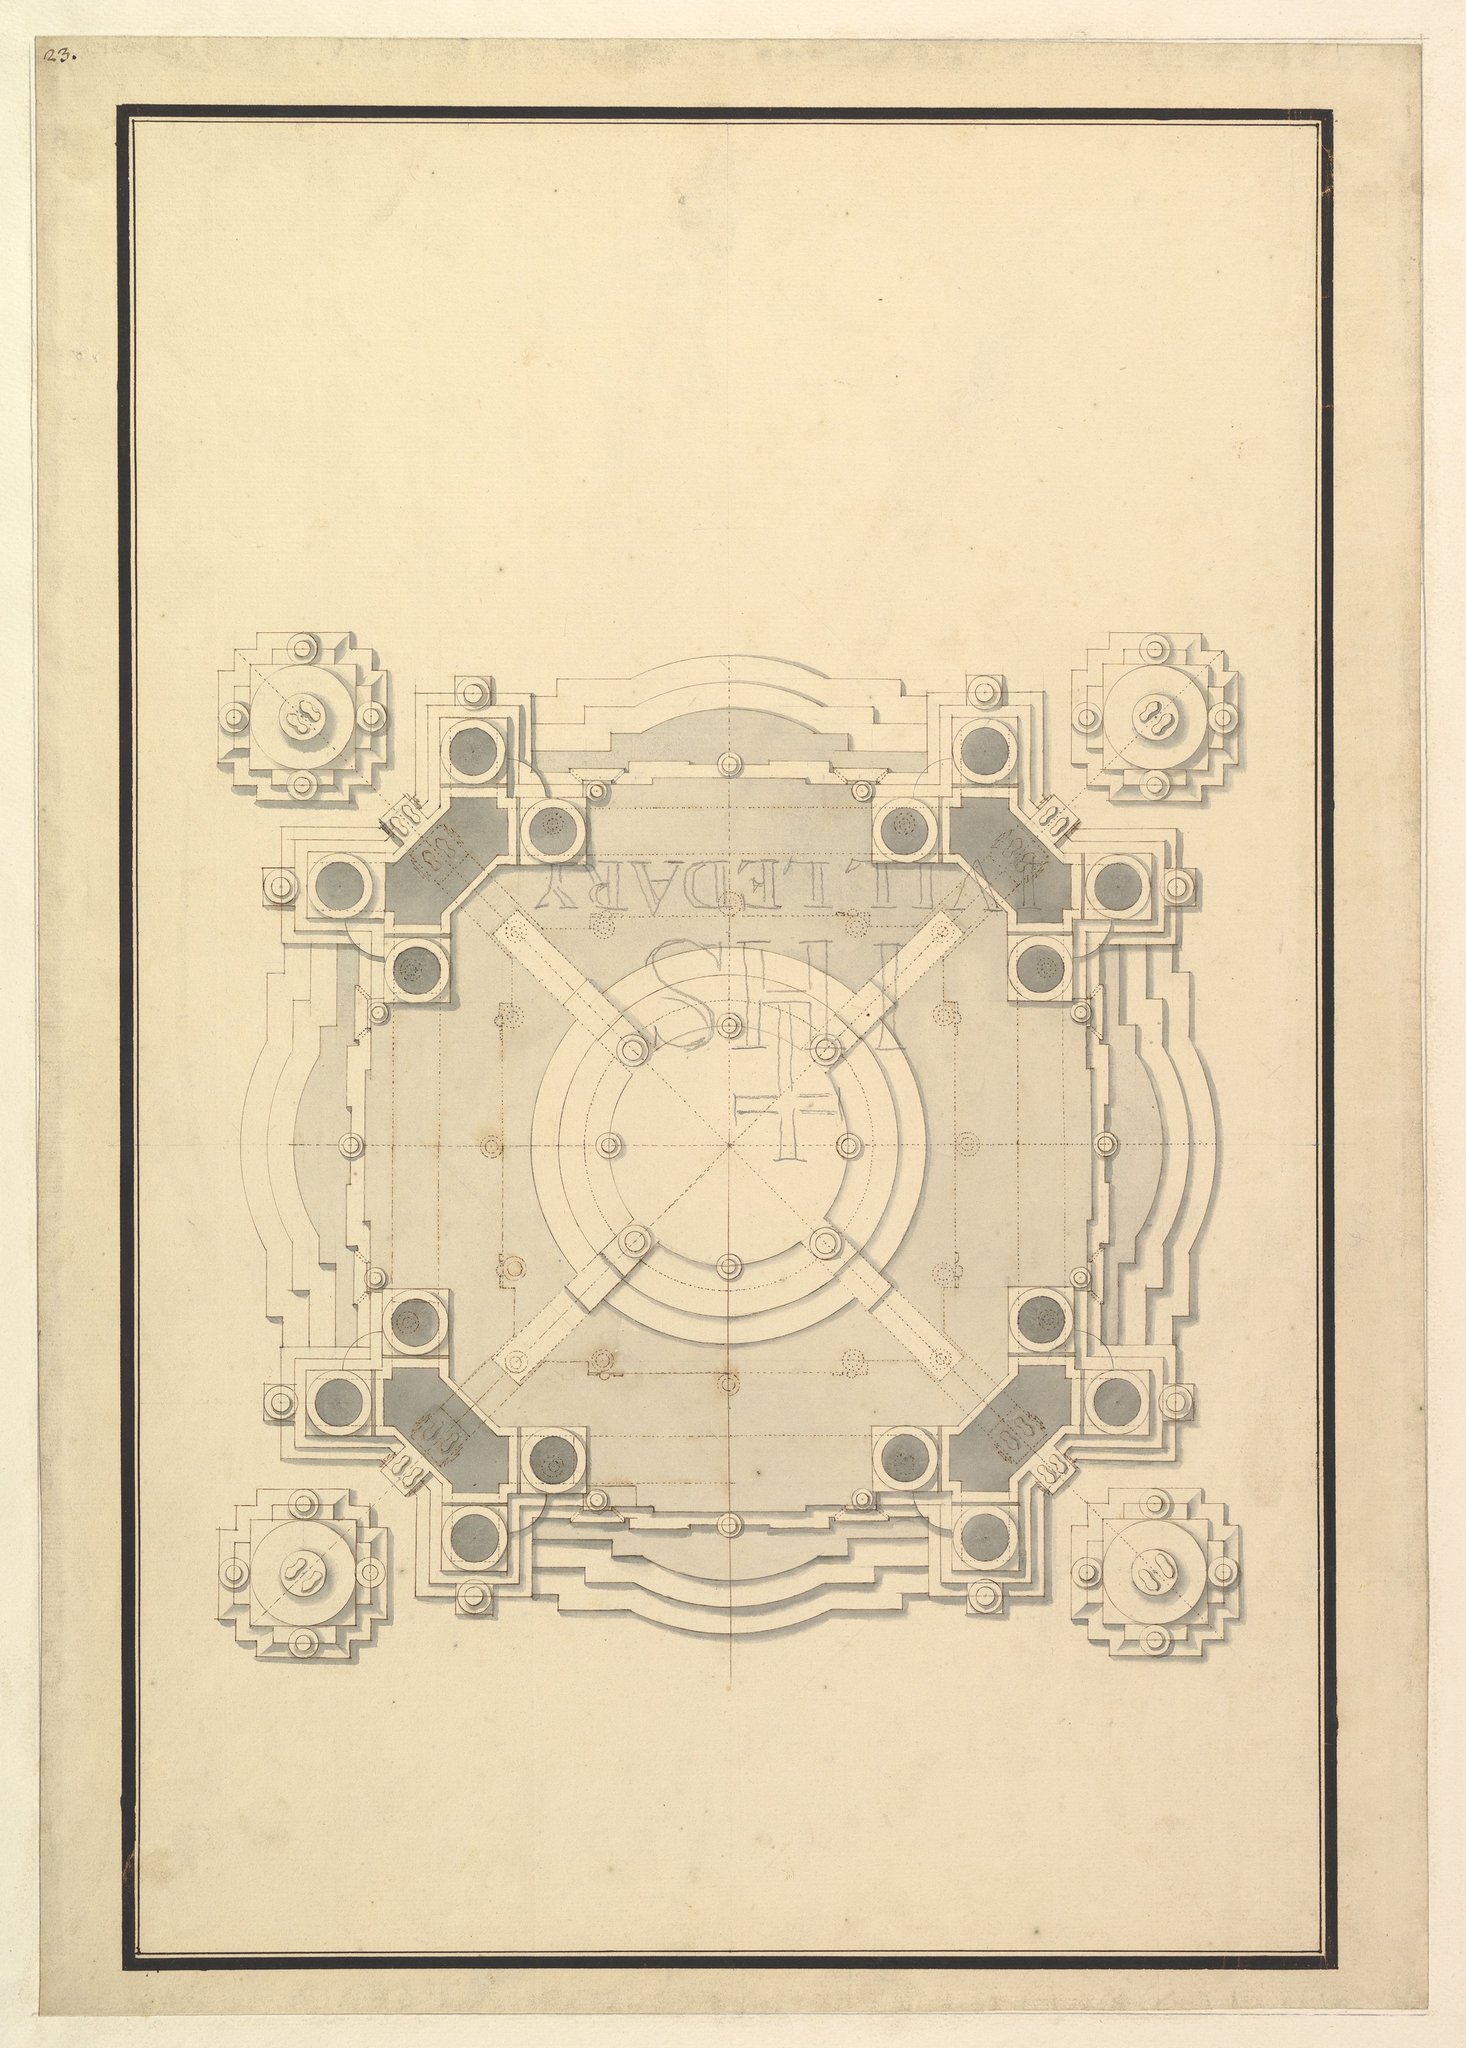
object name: drawing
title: Ground Plan for a Catafalque for Louis, Dauphin of France, d. 1711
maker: giuseppe galli bibiena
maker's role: artist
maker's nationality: italian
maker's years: 1696-1756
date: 1711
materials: ink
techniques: pen, wash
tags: architecture